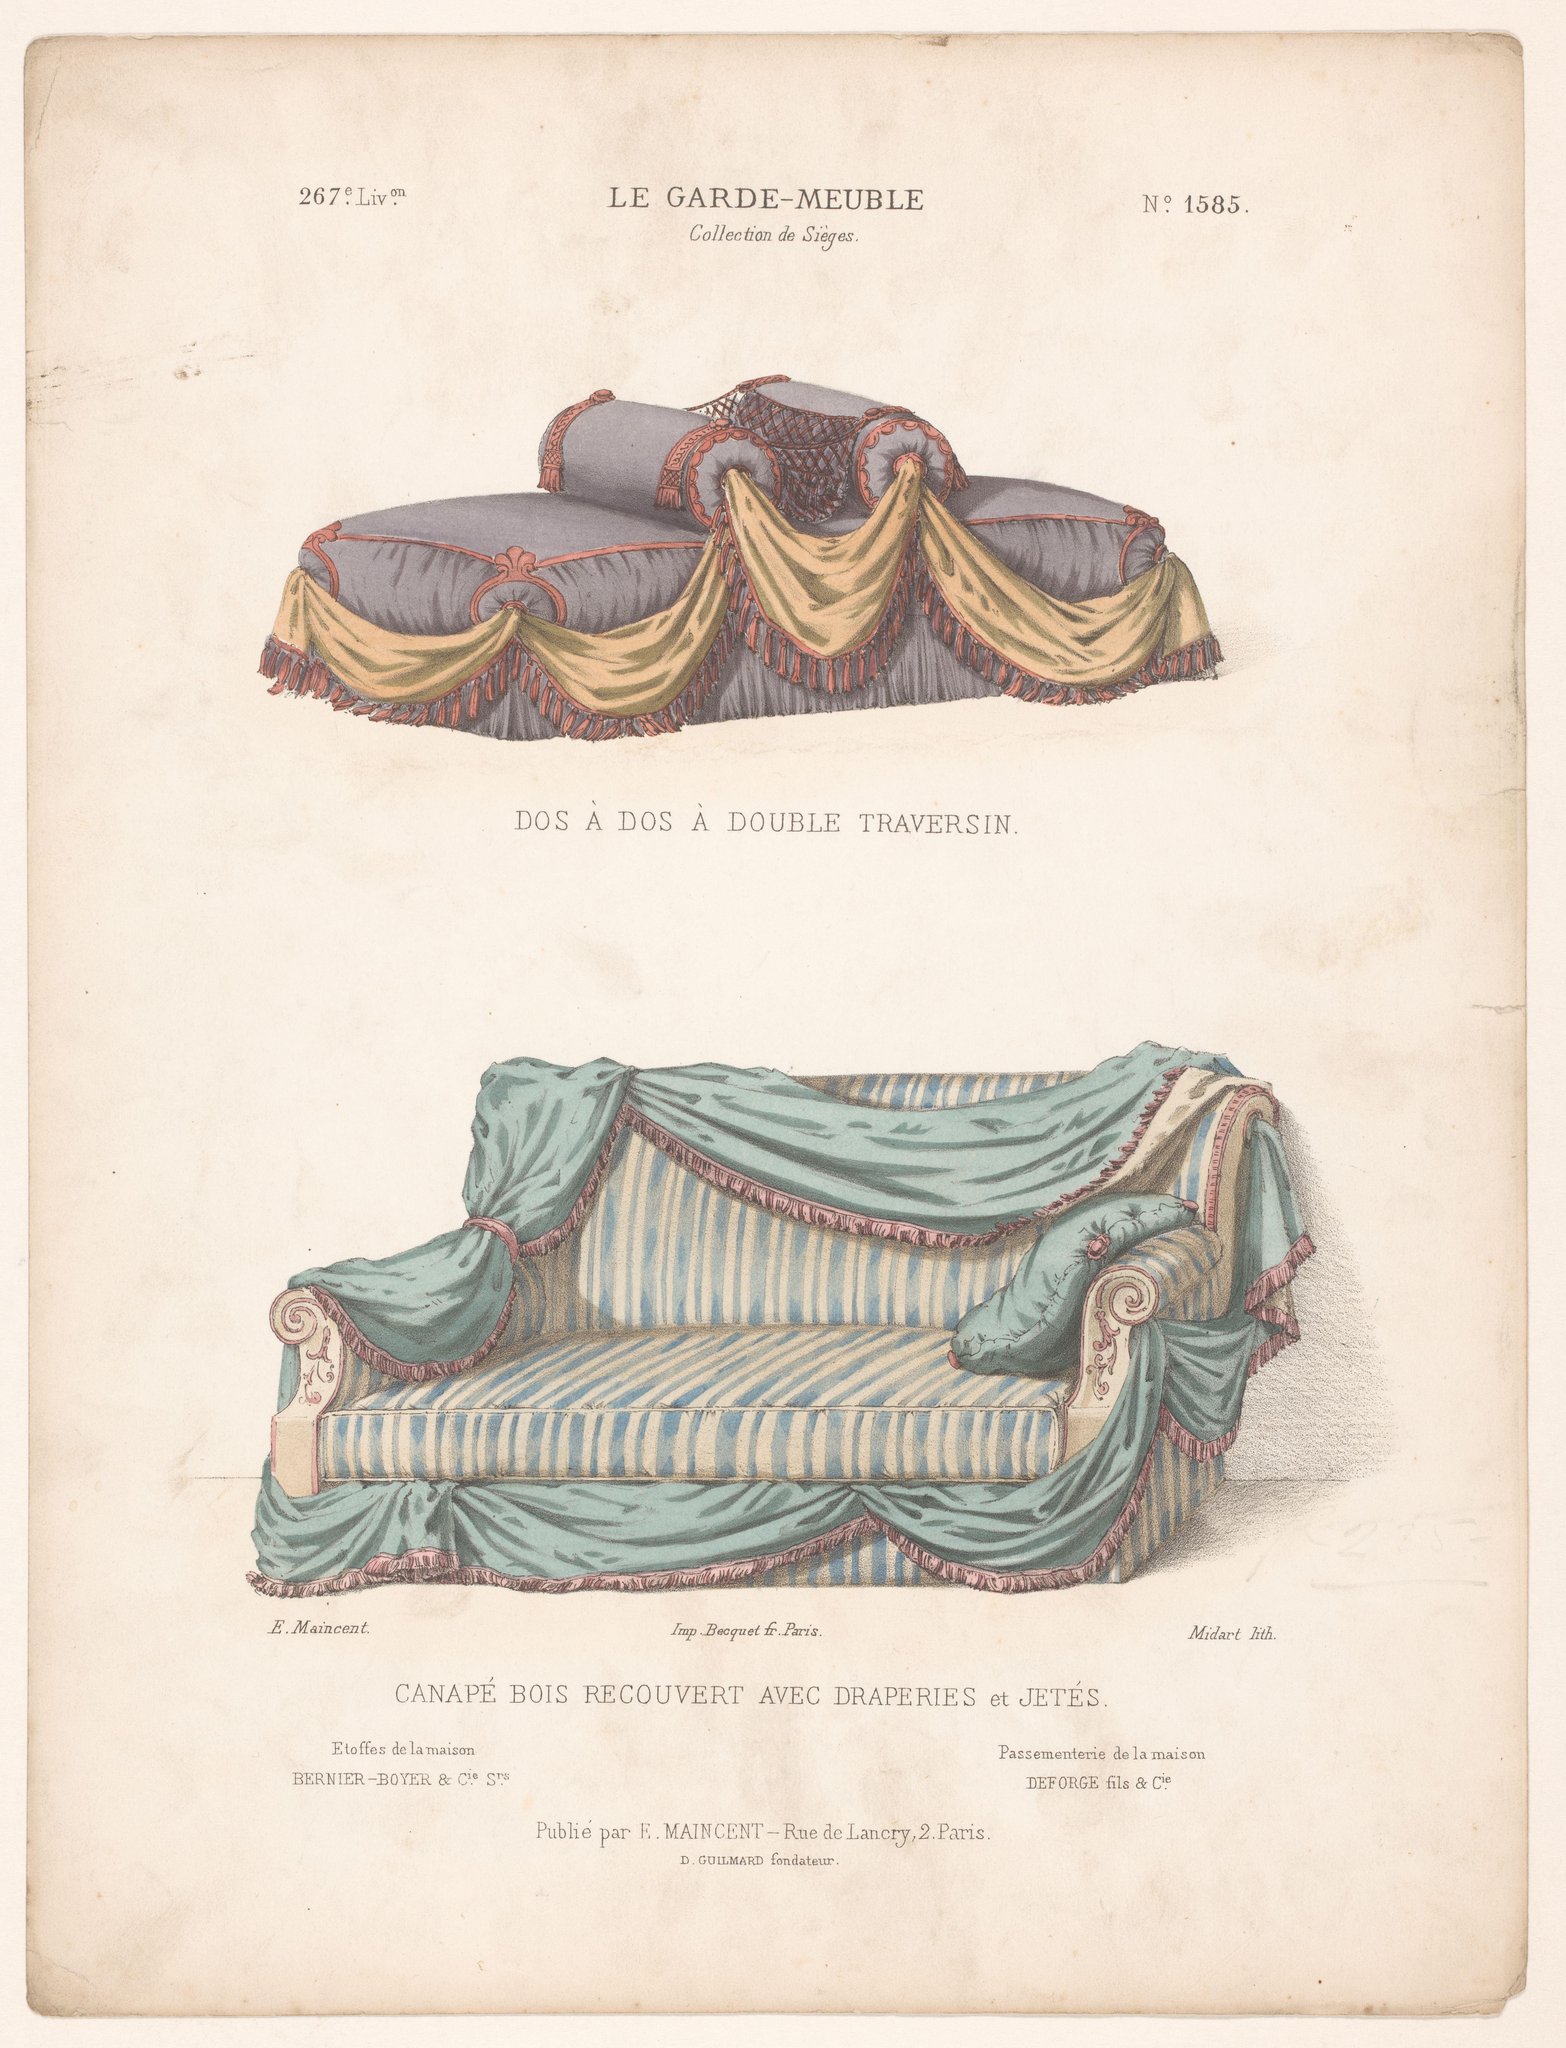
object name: print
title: Dos à dos double traversin / Canapé bois recouvert avec draperies et jetés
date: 1885-1895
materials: paper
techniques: hand coloring, lithograph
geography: paris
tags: seating furniture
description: Ieder Livraison in de serie Le Garde-Meuble bevat negen platen: drie 'sièges' (zitmeubels), drie 'meubles' (diverse meubels zoals tafels en kasten) en drie 'tentures' (gordijnen en draperieën).